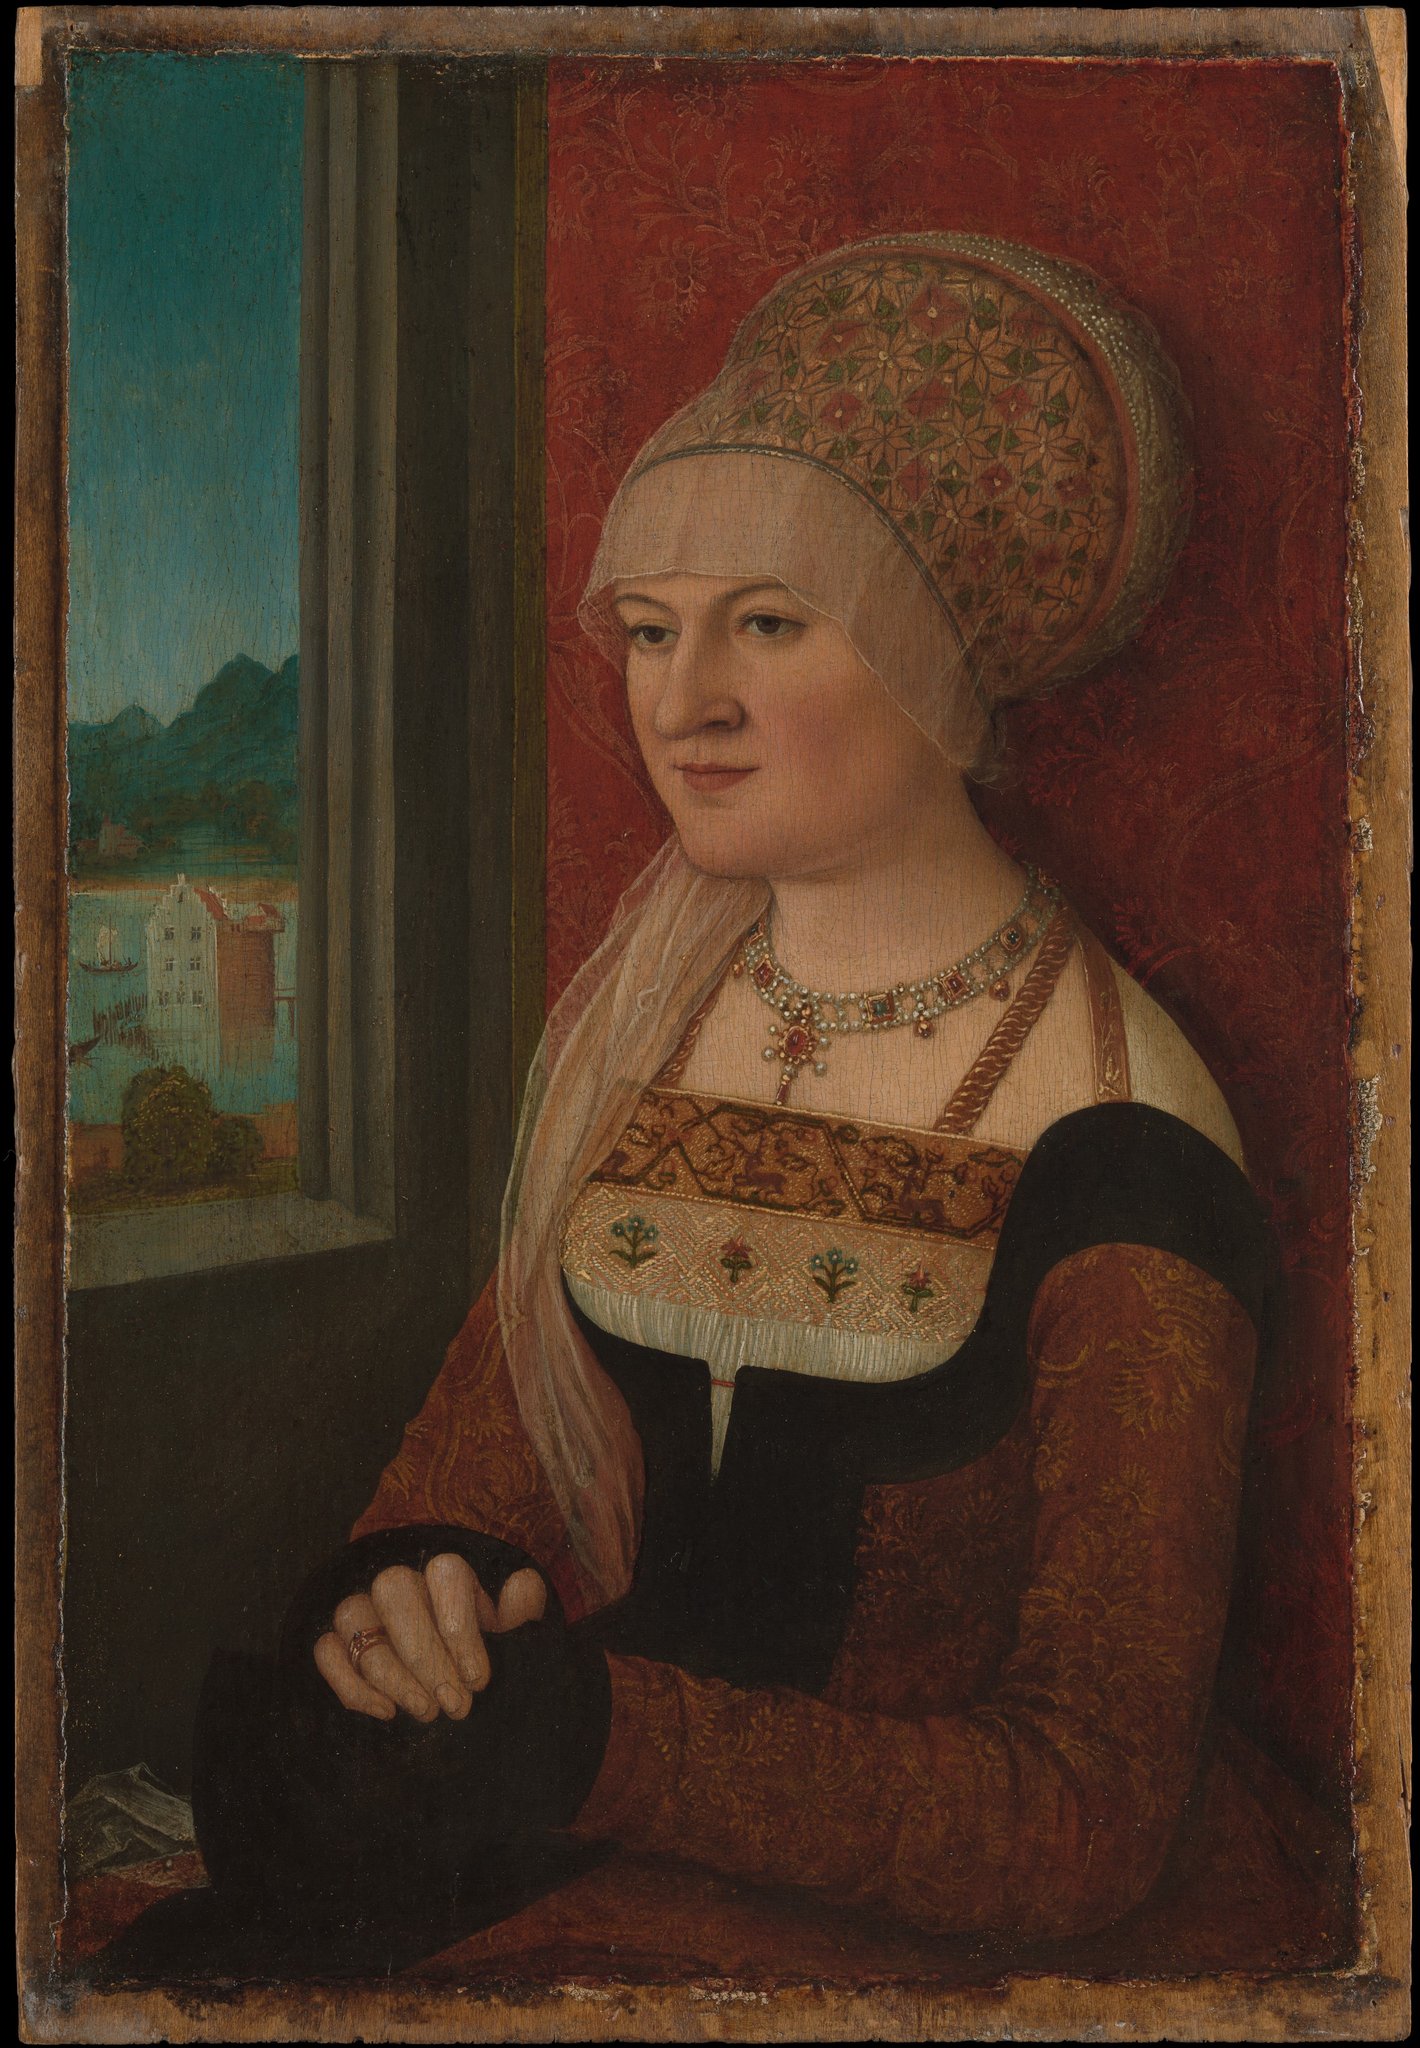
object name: painting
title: Portrait of a Woman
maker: bernhard strigel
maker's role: artist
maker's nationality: german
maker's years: 1460-1528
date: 1510-1515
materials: wood, oil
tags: portraits,women